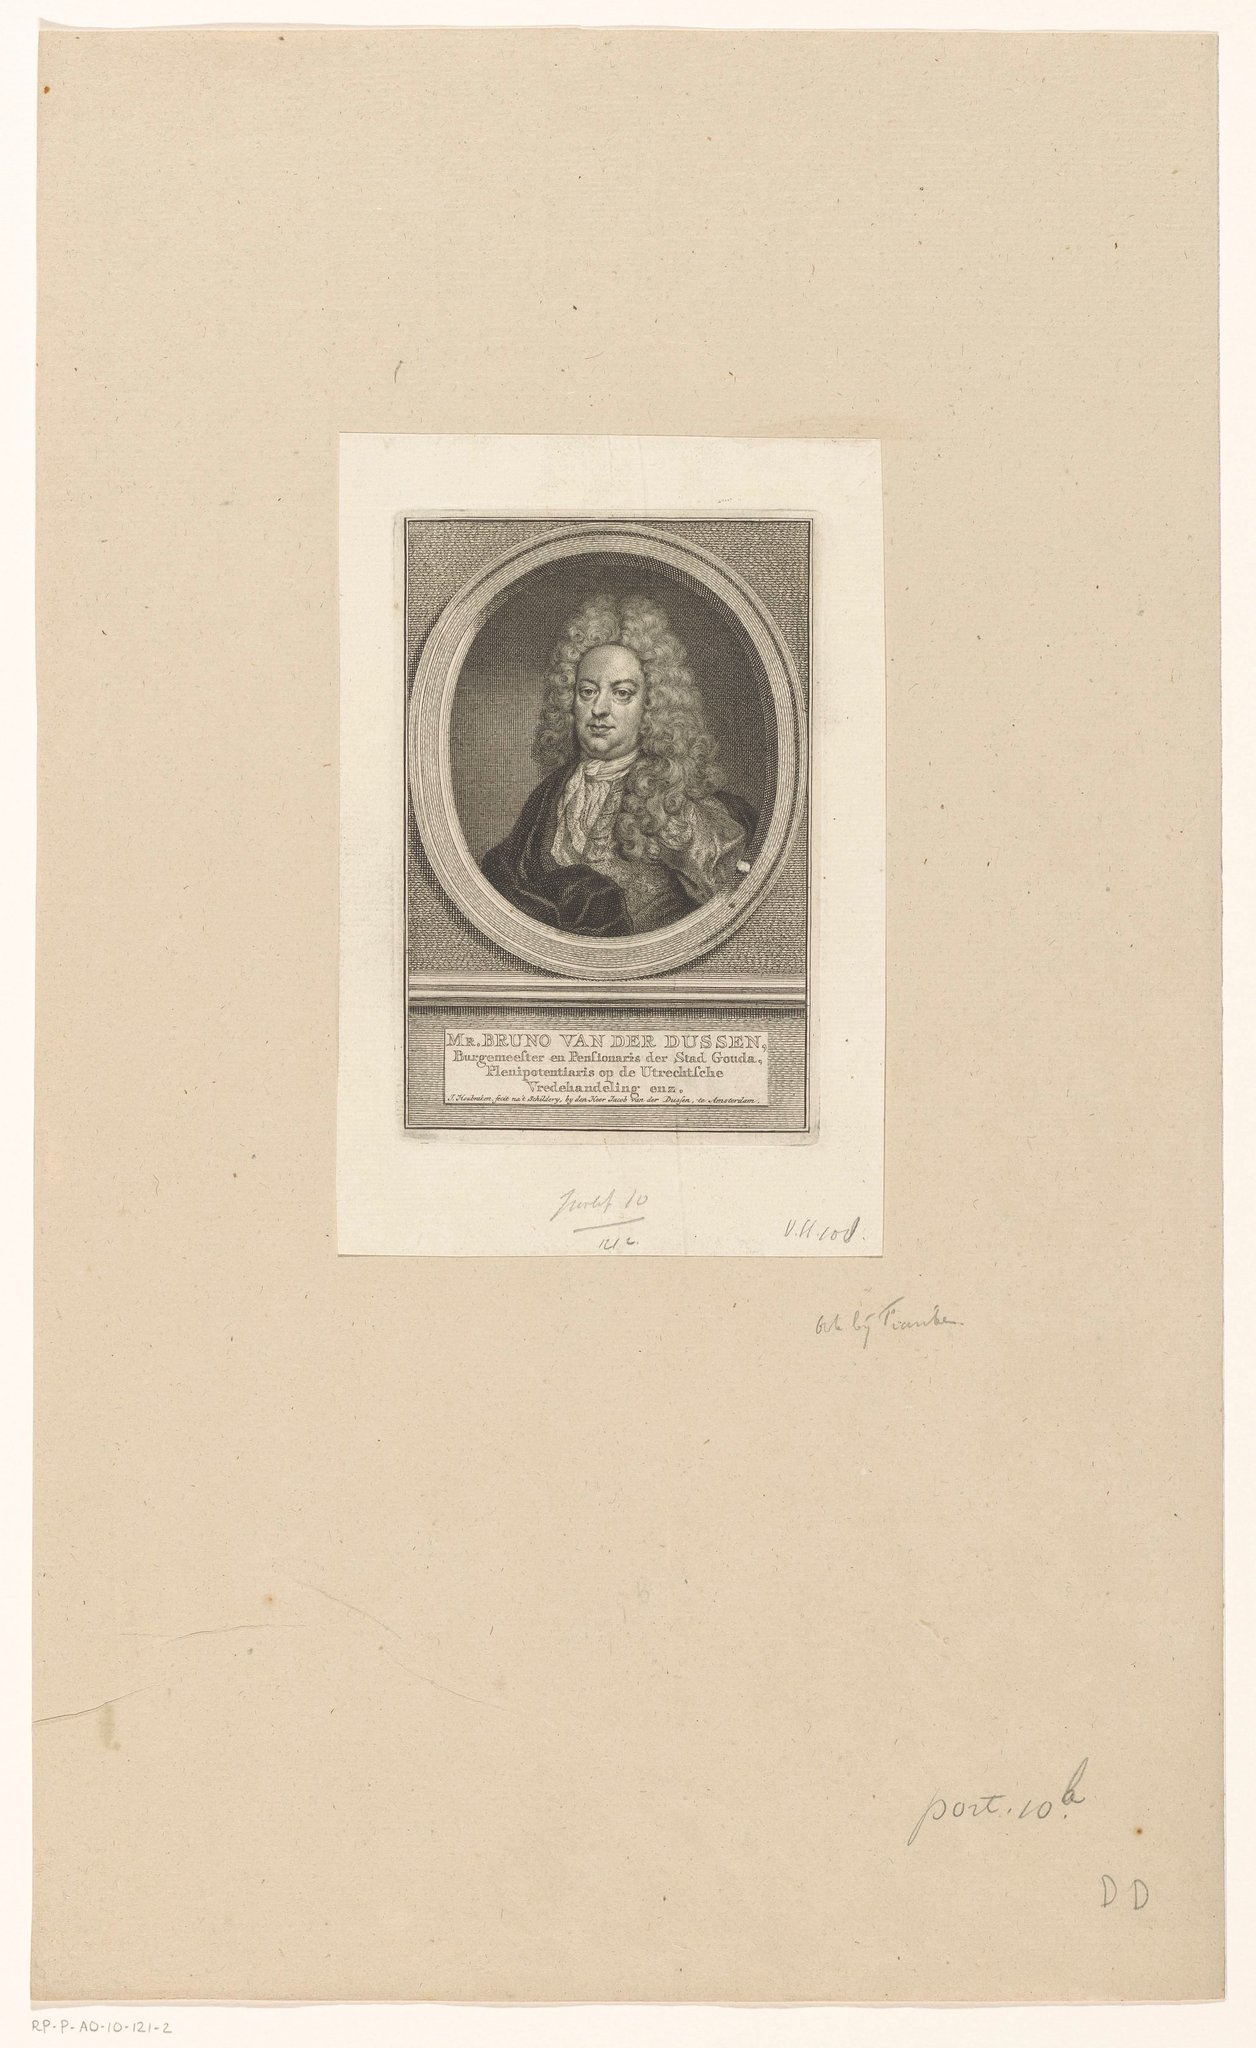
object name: print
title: Portret van Bruno van der Dussen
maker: jacob houbraken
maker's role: draughtsman, print maker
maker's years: 1698-1780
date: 1749-1780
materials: paper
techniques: engraving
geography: amsterdam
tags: bruno van der dussen, historical persons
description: Deze prent is oorspronkelijk bedoeld als aanvulling op Jan Wagenaars ‘Vaderlandsche historie’* en was zo vanaf 1796 verkrijgbaar bij Johannes Allart te Amsterdam. Voor de advertentie waarin Allart de 60 portretten en 7 platen, allen gegraveerd door Houbraken, ter aanvulling op Wagenaars ‘Vaderlandsche historie’ aanbiedt, zie RP-P-OB-77.766. *Van dit werk zijn in de achttiende eeuw meerdere uitgaves verschenen, zoals: Wagenaar, Jan. Vaderlandsche historie, vervattende de geschiedenissen der Vereenigde Nederlanden (…). 21 delen. Amsterdam: Isaak Tirion, 1749-1759. Wagenaar, Jan. Vaderlandsche historie, vervattende de geschiedenissen der nu Vereenigde Nederlanden (…). 21 delen. Amsterdam: weduwe Isaak Tirion, 1770. Wagenaar, Jan. Vaderlandsche historie, vervattende de geschiedenissen der nu Vereenigde Nederlanden (…). 21 delen. Amsterdam, Leiden, Dordrecht en Harlingen: P. Schouten e.a., 1782. Wagenaar, Jan. Vaderlandsche historie, vervattende de geschiedenissen der nu Vereenigde Nederlanden (…). 21 delen. Amsterdam: Johannes Allart, 1790-1796.